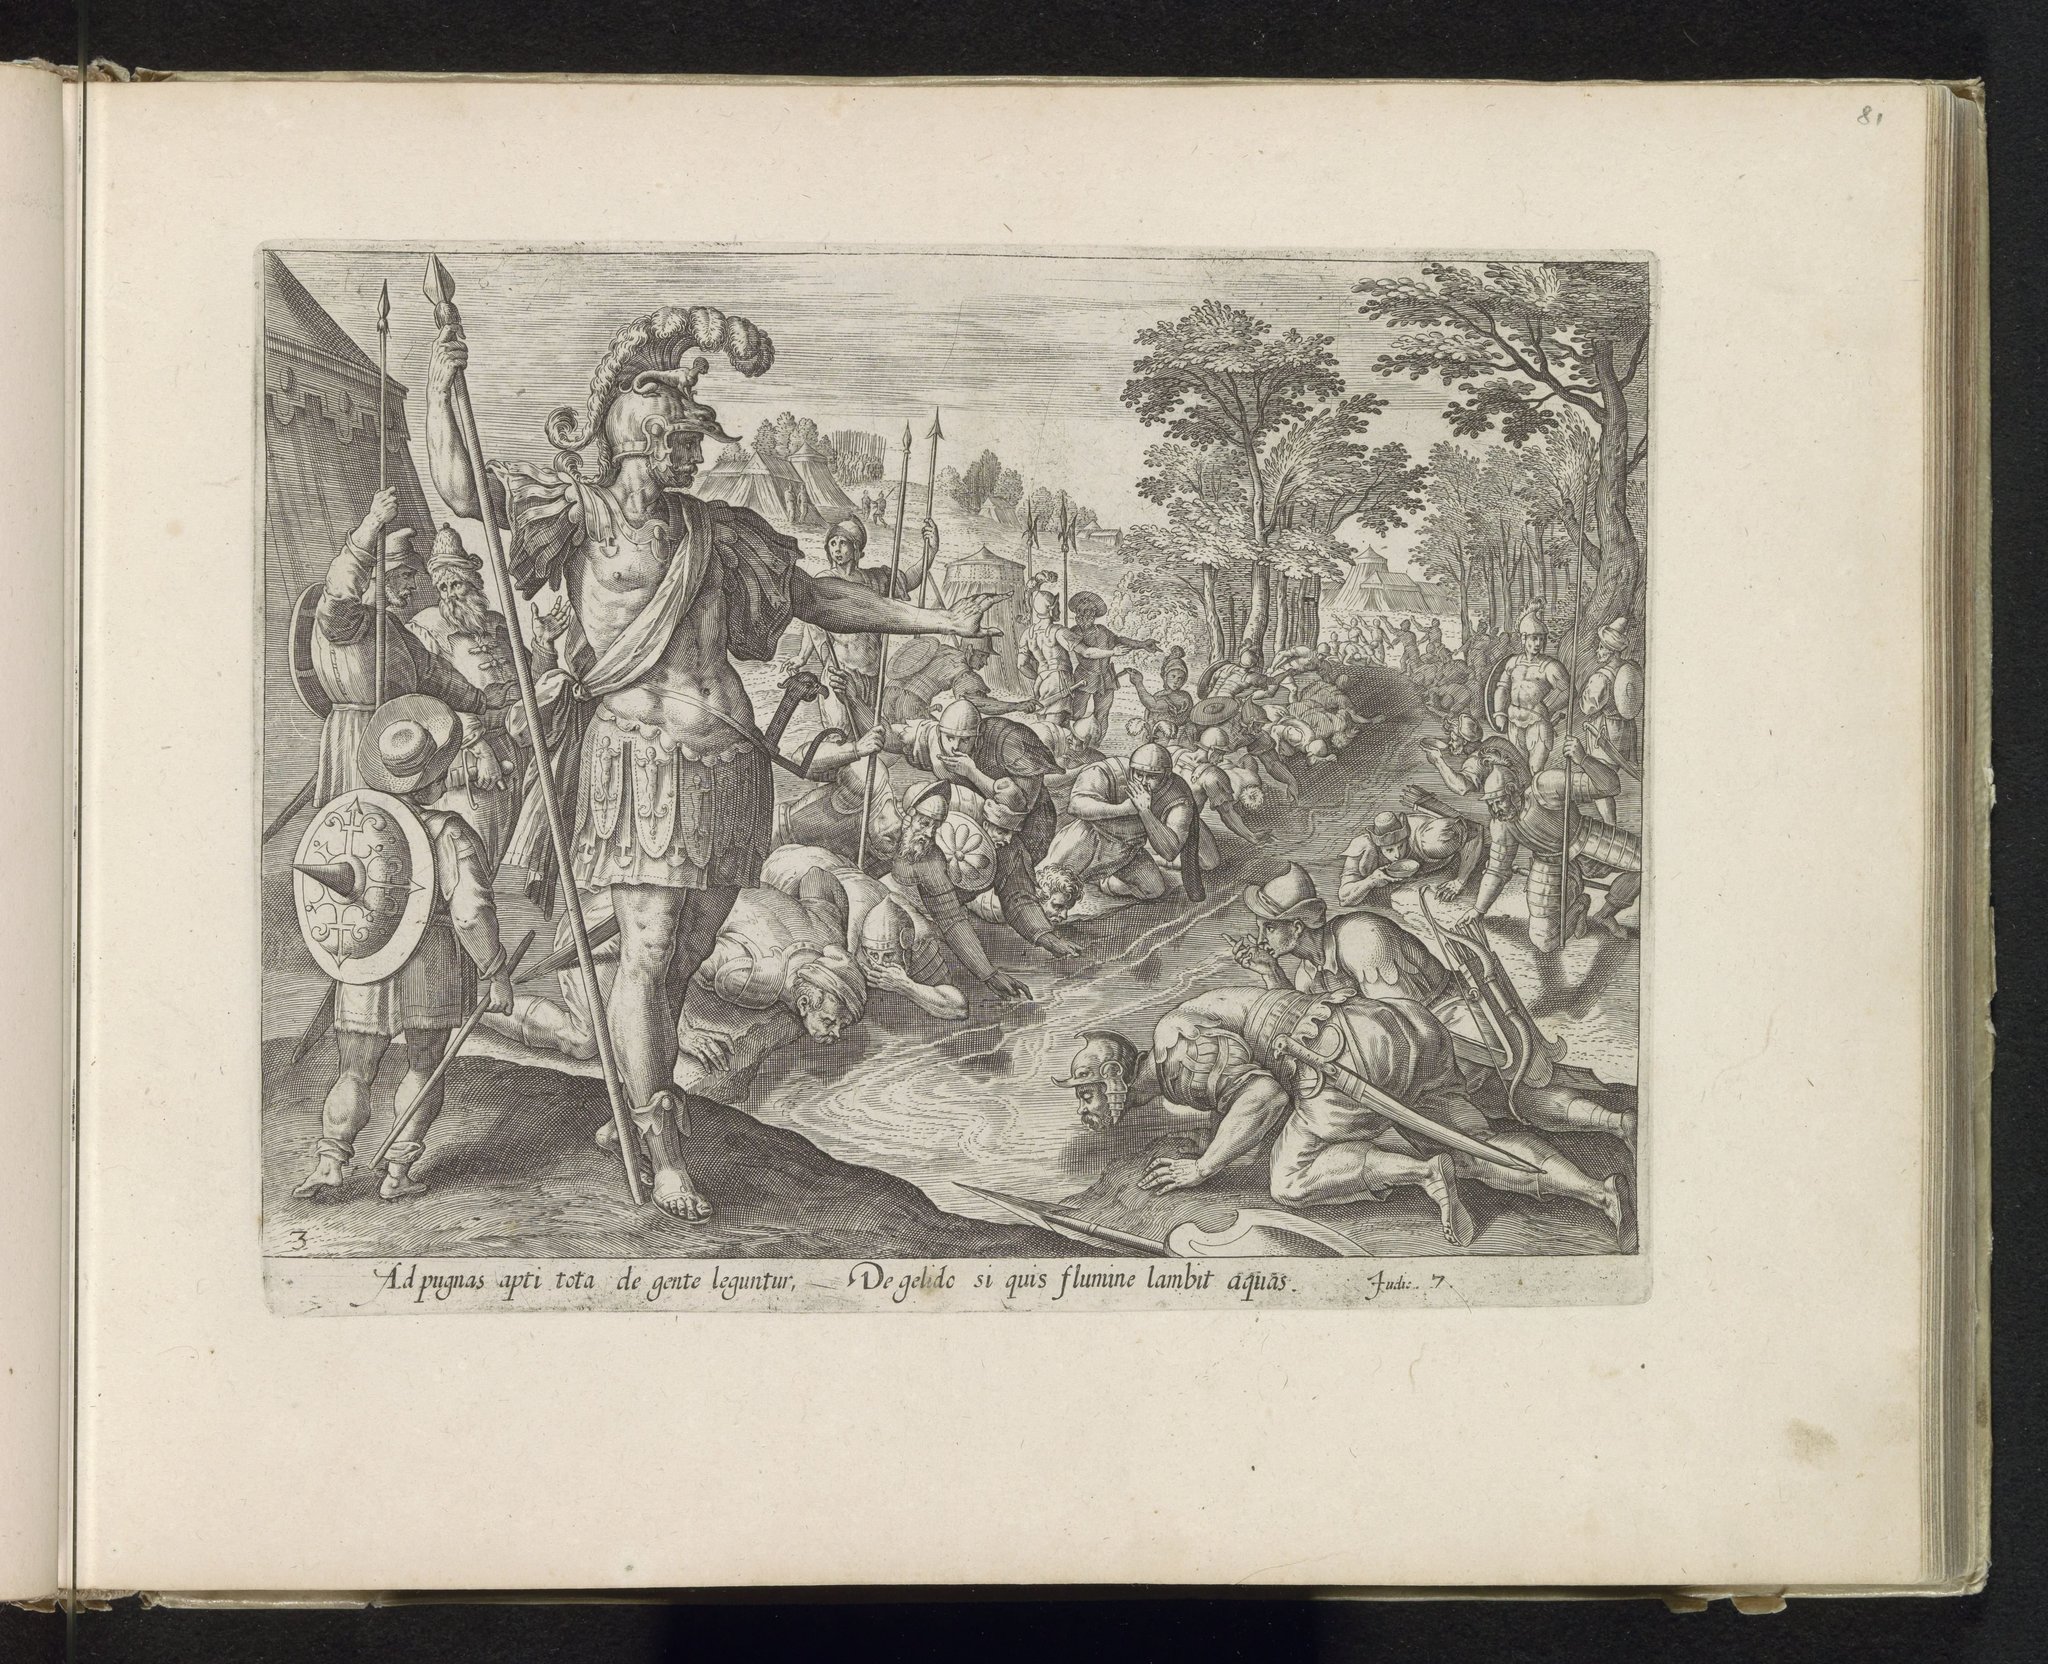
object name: print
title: Thesaurus sacrarum historiaru[m] veteris testame[n]ti, elega[n]tissimis imaginibus expressu[m] excelle[n]tissimoru[m] in hac arte viroru[m] opera: nu[n]c primu[m] in luce[m] editus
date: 1585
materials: paper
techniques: engraving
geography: antwerp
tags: those who lap water by putting their hand to their mouth are separated from those who kneel down to drink the water ~ selection of gideon's men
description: Gideon heeft zijn mannen naar het water gebracht en laat hen drinken. Degenen die het water met hun tong oplikken neemt hij mee in de strijd. De mannen die knielen om het water te drinken worden naar huis gestuurd. Onder de voorstelling een verwijzing in het Latijn naar de Bijbeltekst in Ri. 7. Deze prent maakt deel uit van een album.